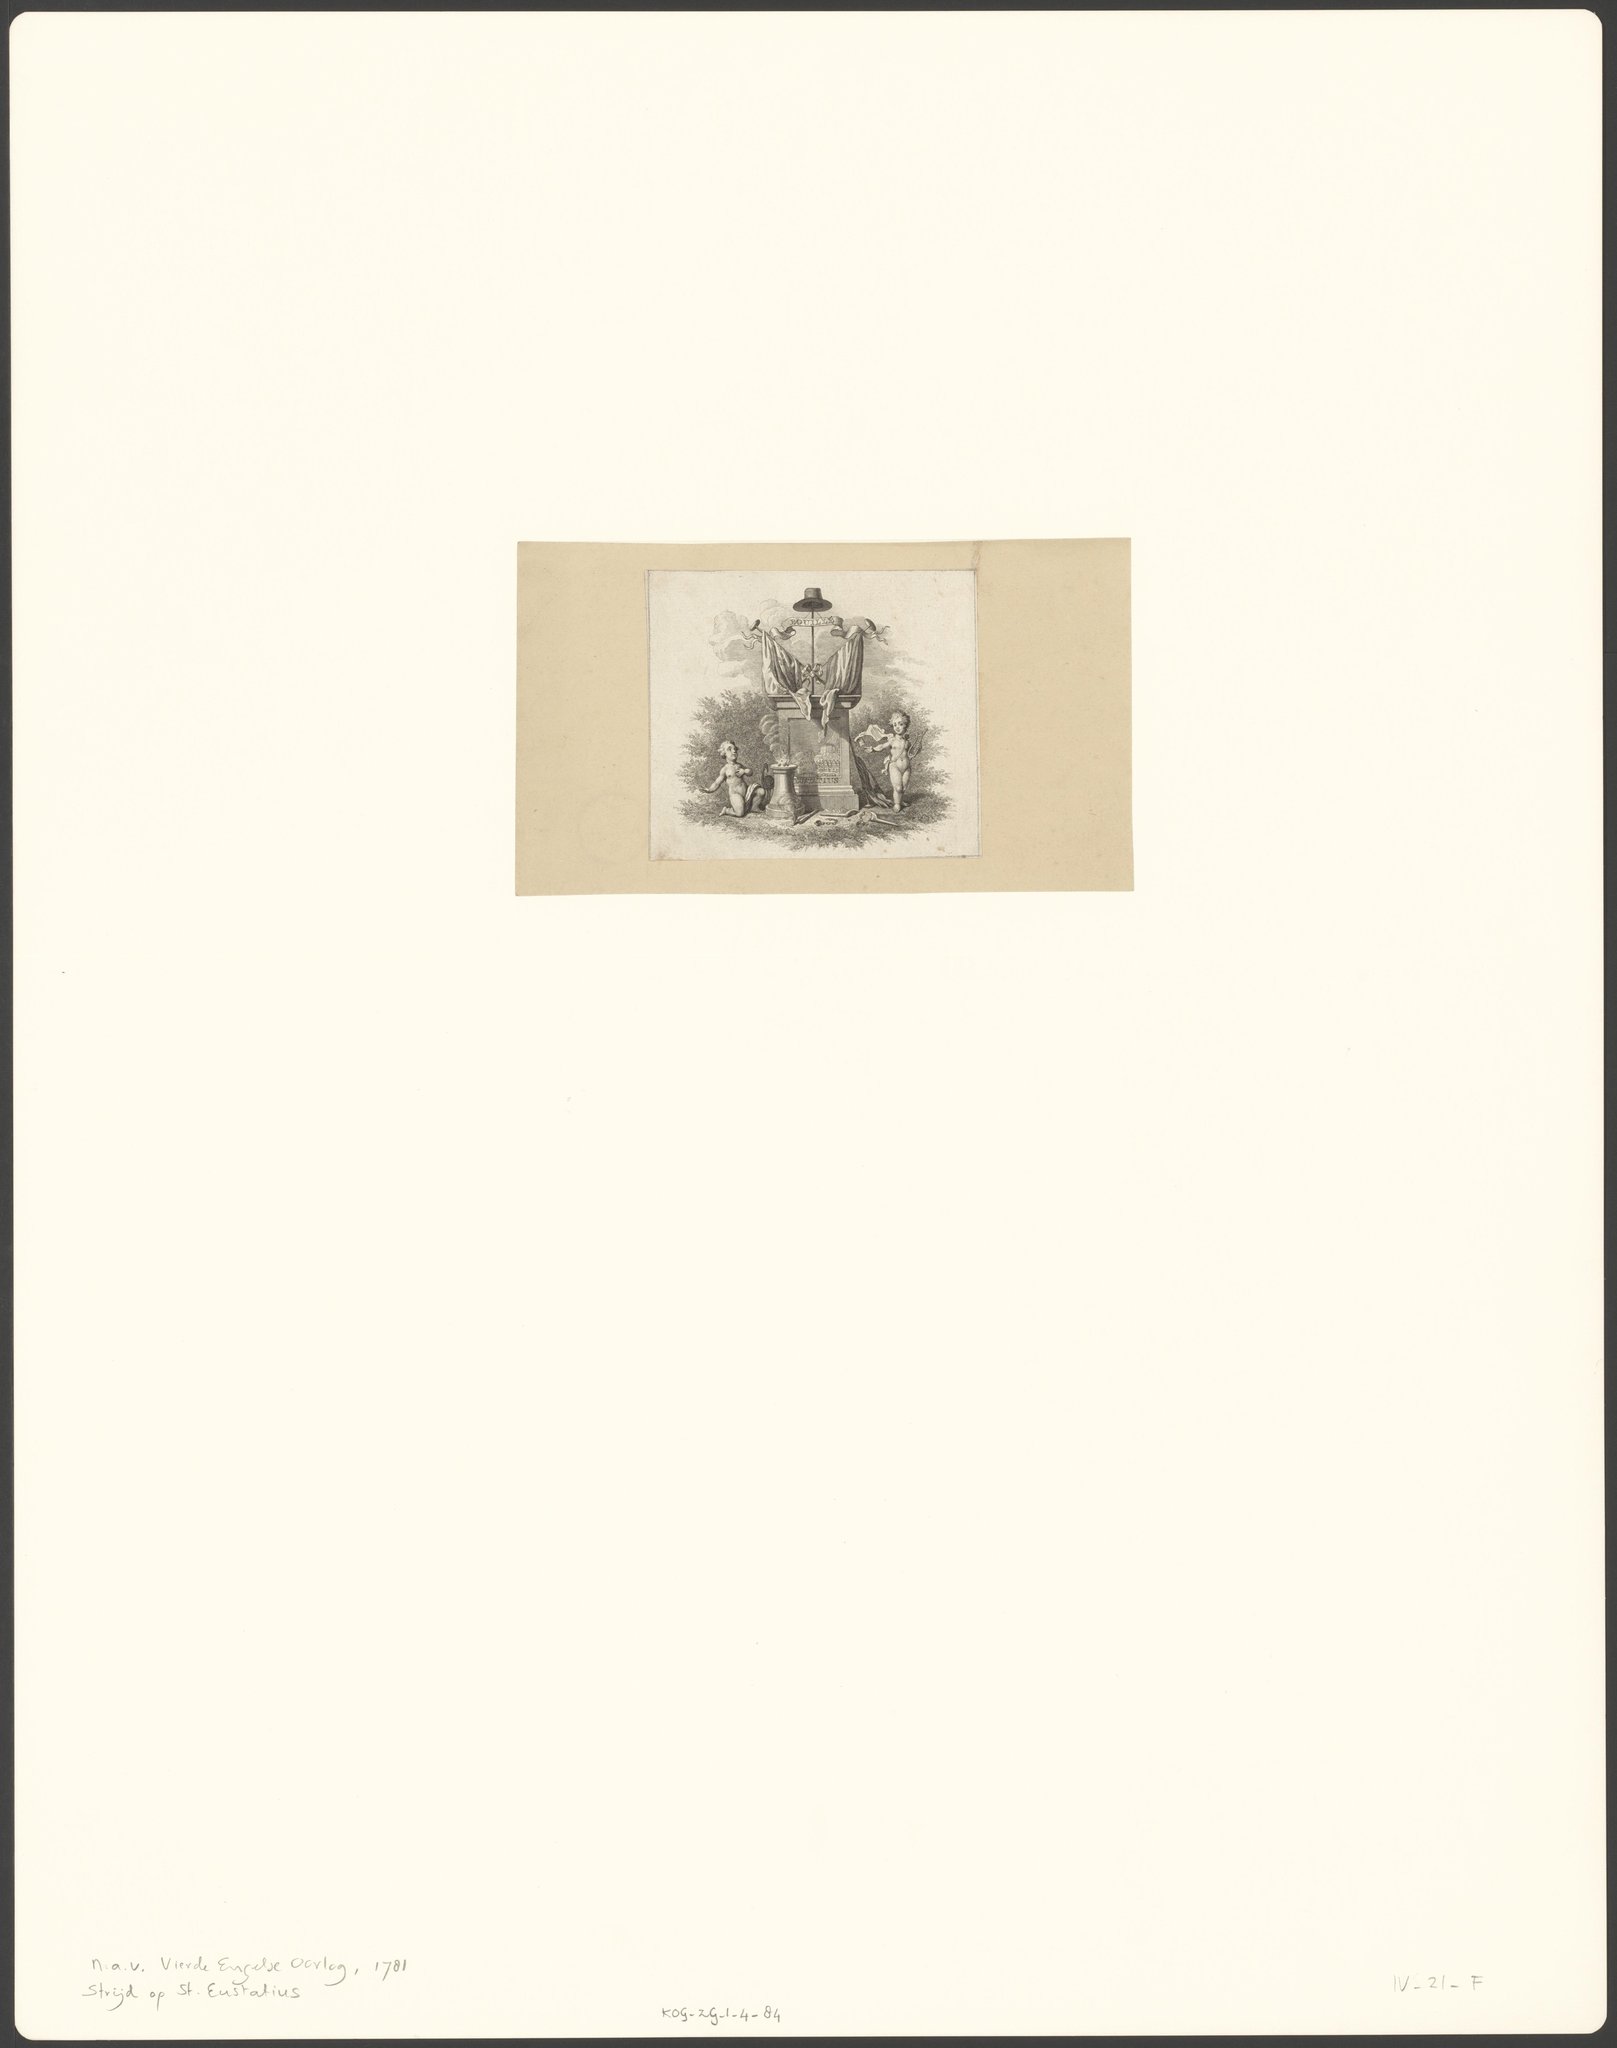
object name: print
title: Vignet strijd op Sint-Eustatius in 1781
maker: Anonymous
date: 1781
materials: paper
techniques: engraving, etching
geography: northern netherlands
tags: fortifications, military engineering, freedom, liberty; 'libertà' (ripa) (+ symbolical representation of concept)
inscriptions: collector's mark: Lugt 1641